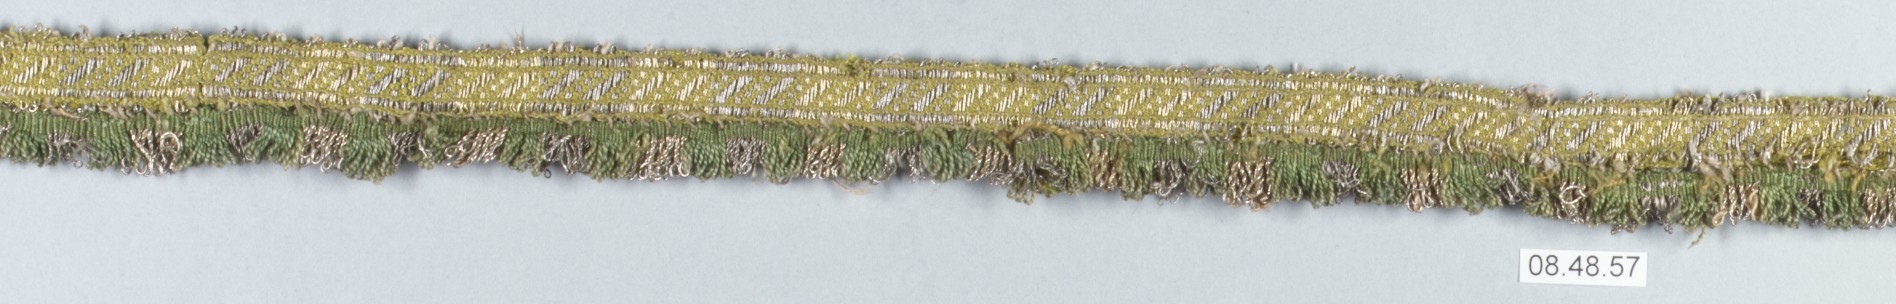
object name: galloon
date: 1601-1633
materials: metal thread